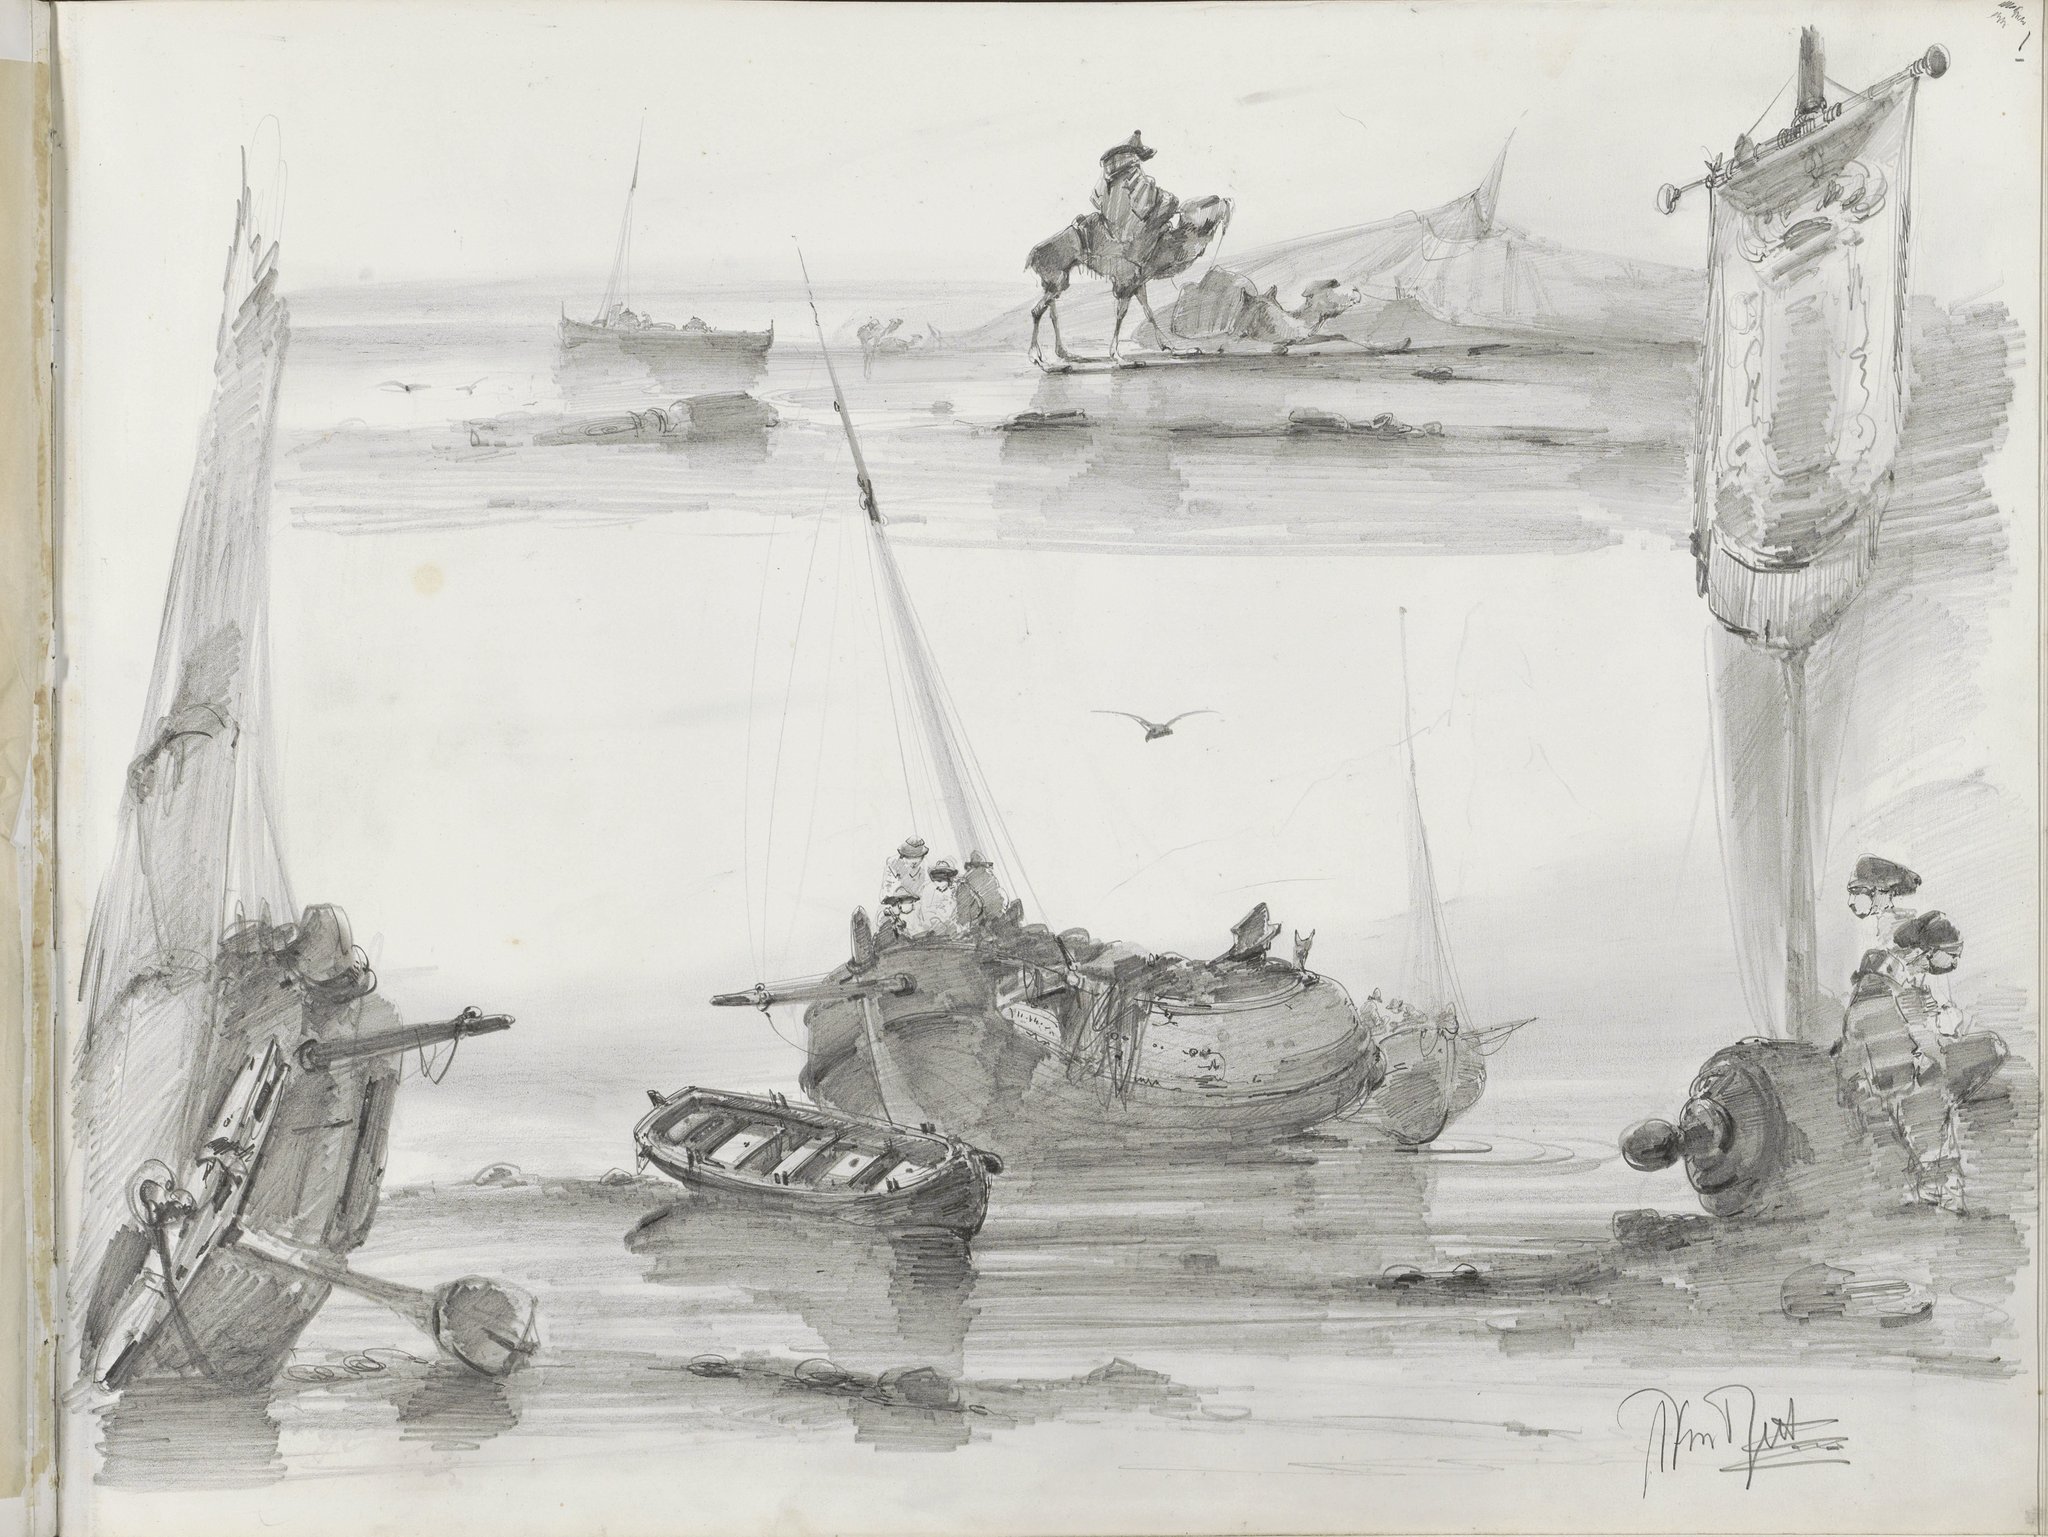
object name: sketchbook leaf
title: Studieblad met aangemeerde bomschuiten en kamelen in een woestijnlandschap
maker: albertus van beest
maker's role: draughtsman, print maker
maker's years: 1820-1860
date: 1830-1860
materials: paper, pencil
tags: hoofed animals: camel, desert (+ landscape (in the non-temperate zone) with figures, staffage), sailing-ship, sailing-boat, (military) flags and standards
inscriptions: signature: ‘AVan Beest’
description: Tevens studies van een gekapseisd zeilschip en een vaandel. Blad 1 recto uit een schetsboek met 46 bladen.